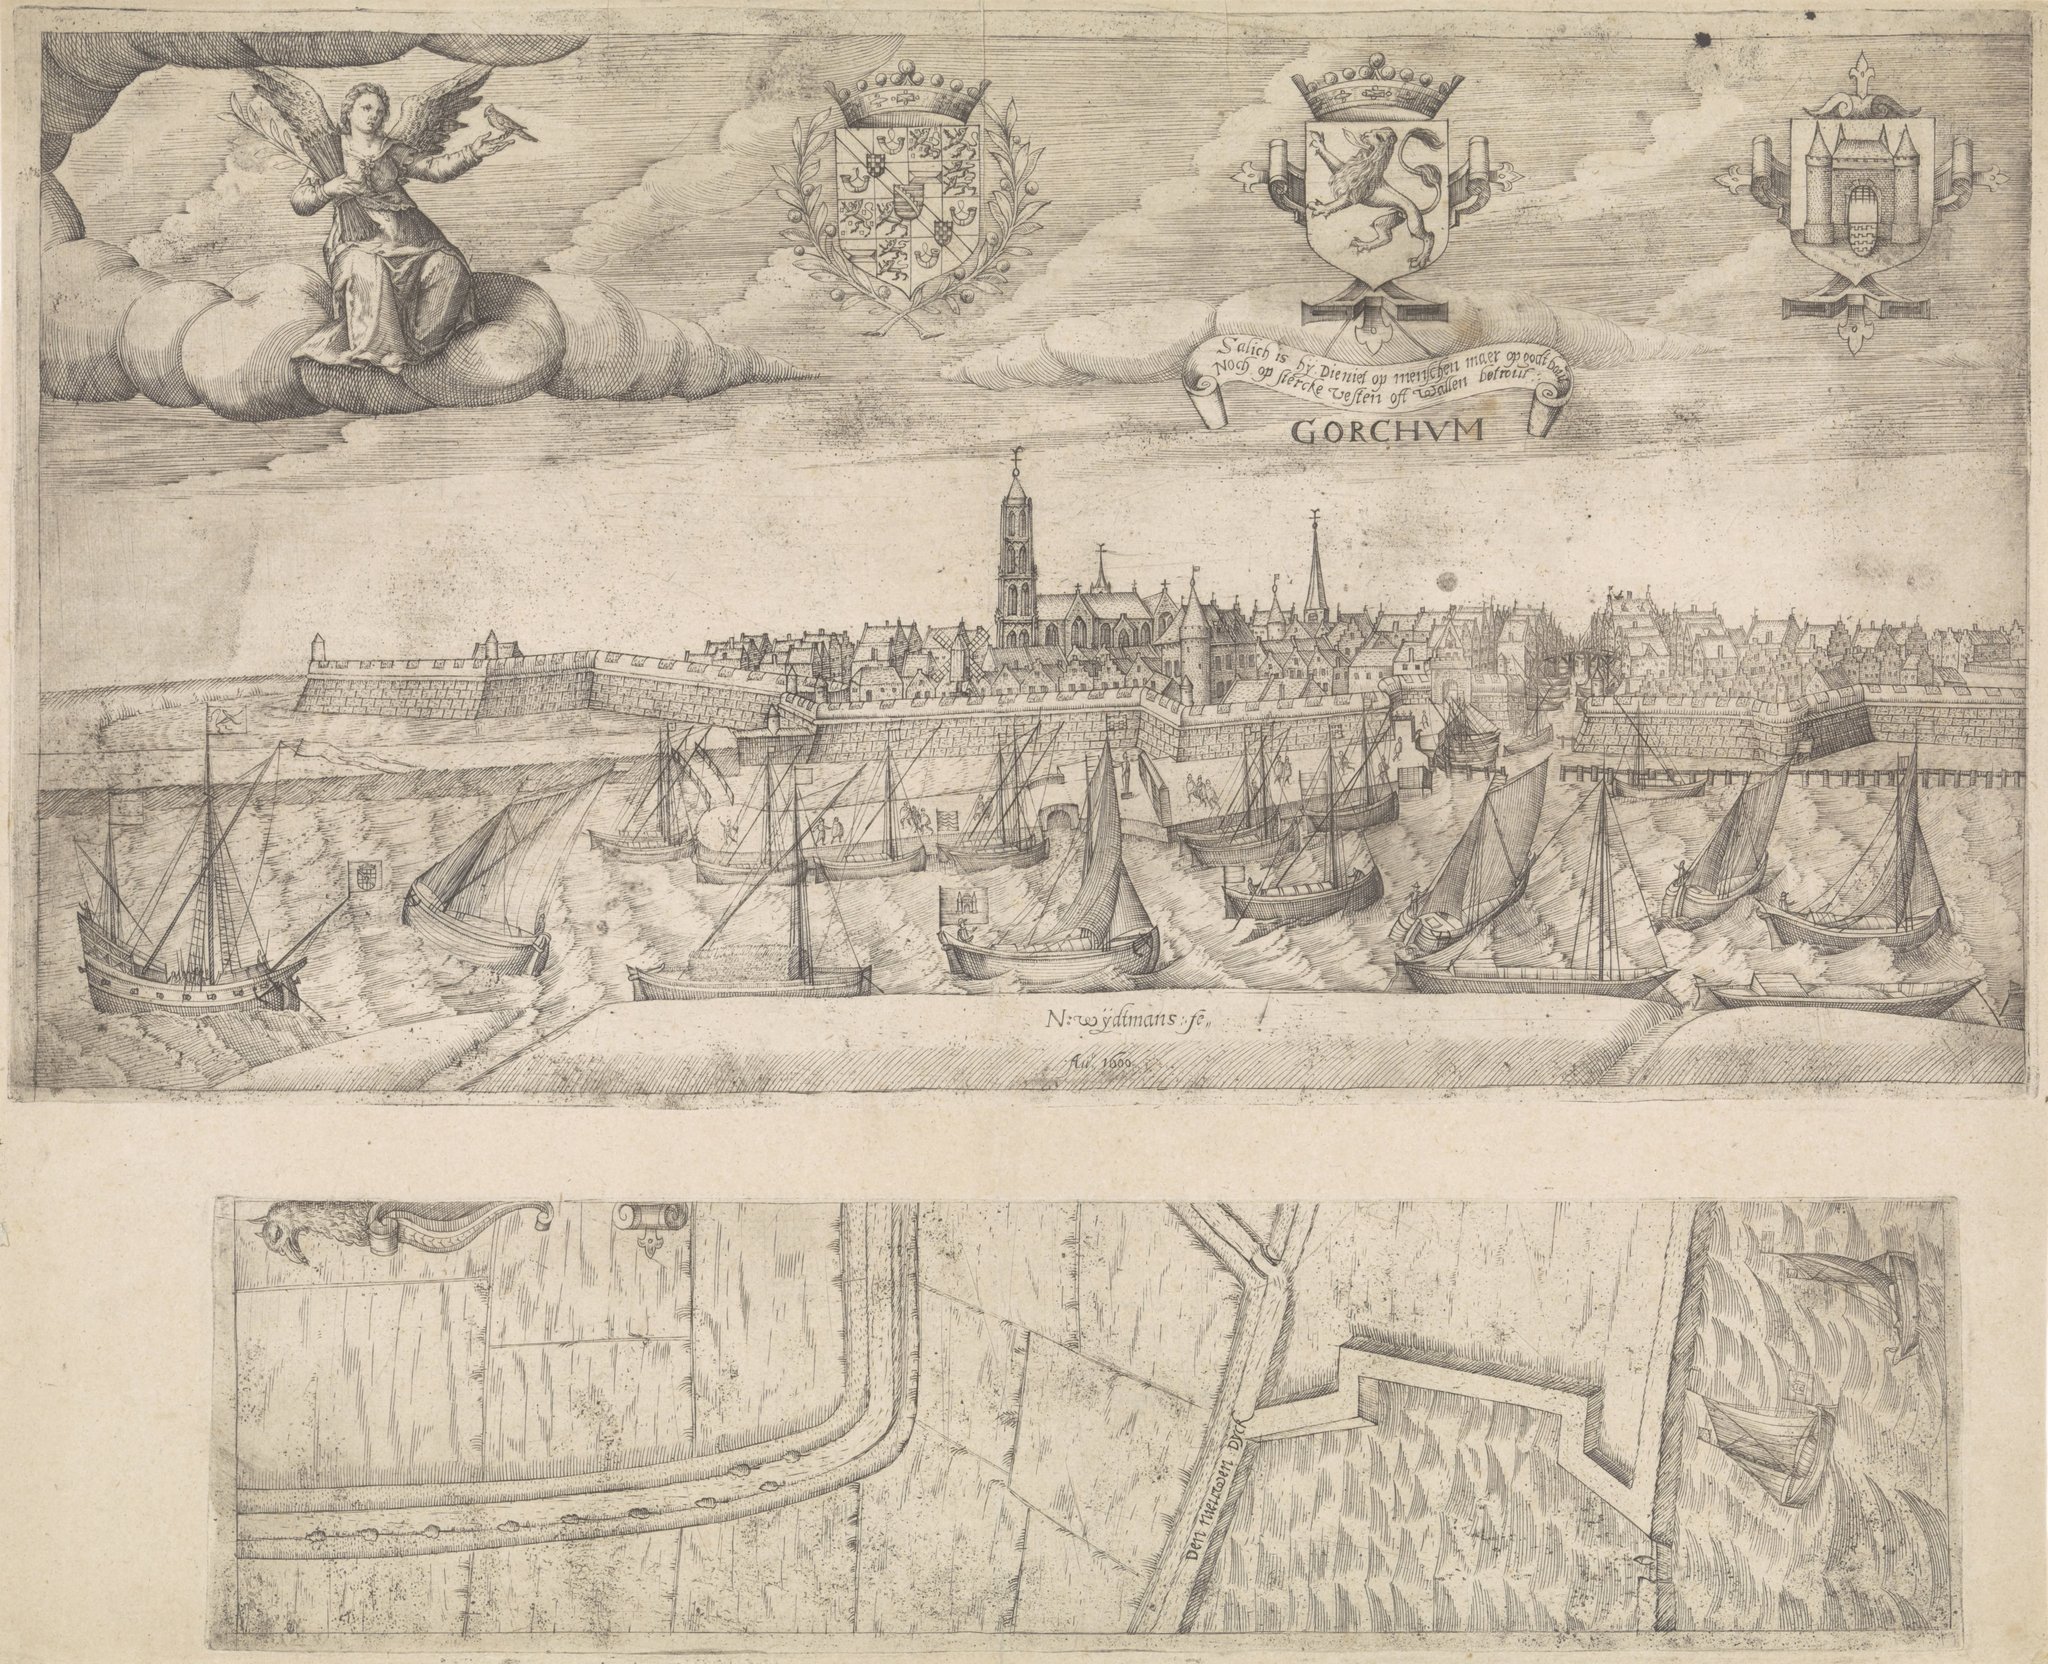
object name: print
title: Gezicht op de stad Gorinchem en linker deel van een plattegrond van Gorinchem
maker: nicolaes weydtmans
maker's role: print maker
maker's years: 1570-1642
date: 1600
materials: paper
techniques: engraving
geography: gorinchem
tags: sailing-ship, sailing-boat, city-view in general; 'veduta'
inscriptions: collector's mark: Lugt 2760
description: Twee voorstellingen op een blad. Boven: Gezicht op de stad Gorinchem. Op de voorgrond de Merwede met verschillende schepen. Linksboven zit een engel op de wolken met een pijlenbundel en een oranjetak onder de arm en een vogel op de hand. Midden links het wapen van prins Maurits, midden rechts het wapen van Holland en rechts het stadswapen van Gorinchem. Onder het wapen van Holland hangt een banderol met het volgende tweeregelige opschrift: Salich is hij Die niet op menschen maer op godt bout. Noch op stercke vesten oft wallen betrout. Onder: Het linker gedeelte van een plattegrond van de stad Gorinchem.